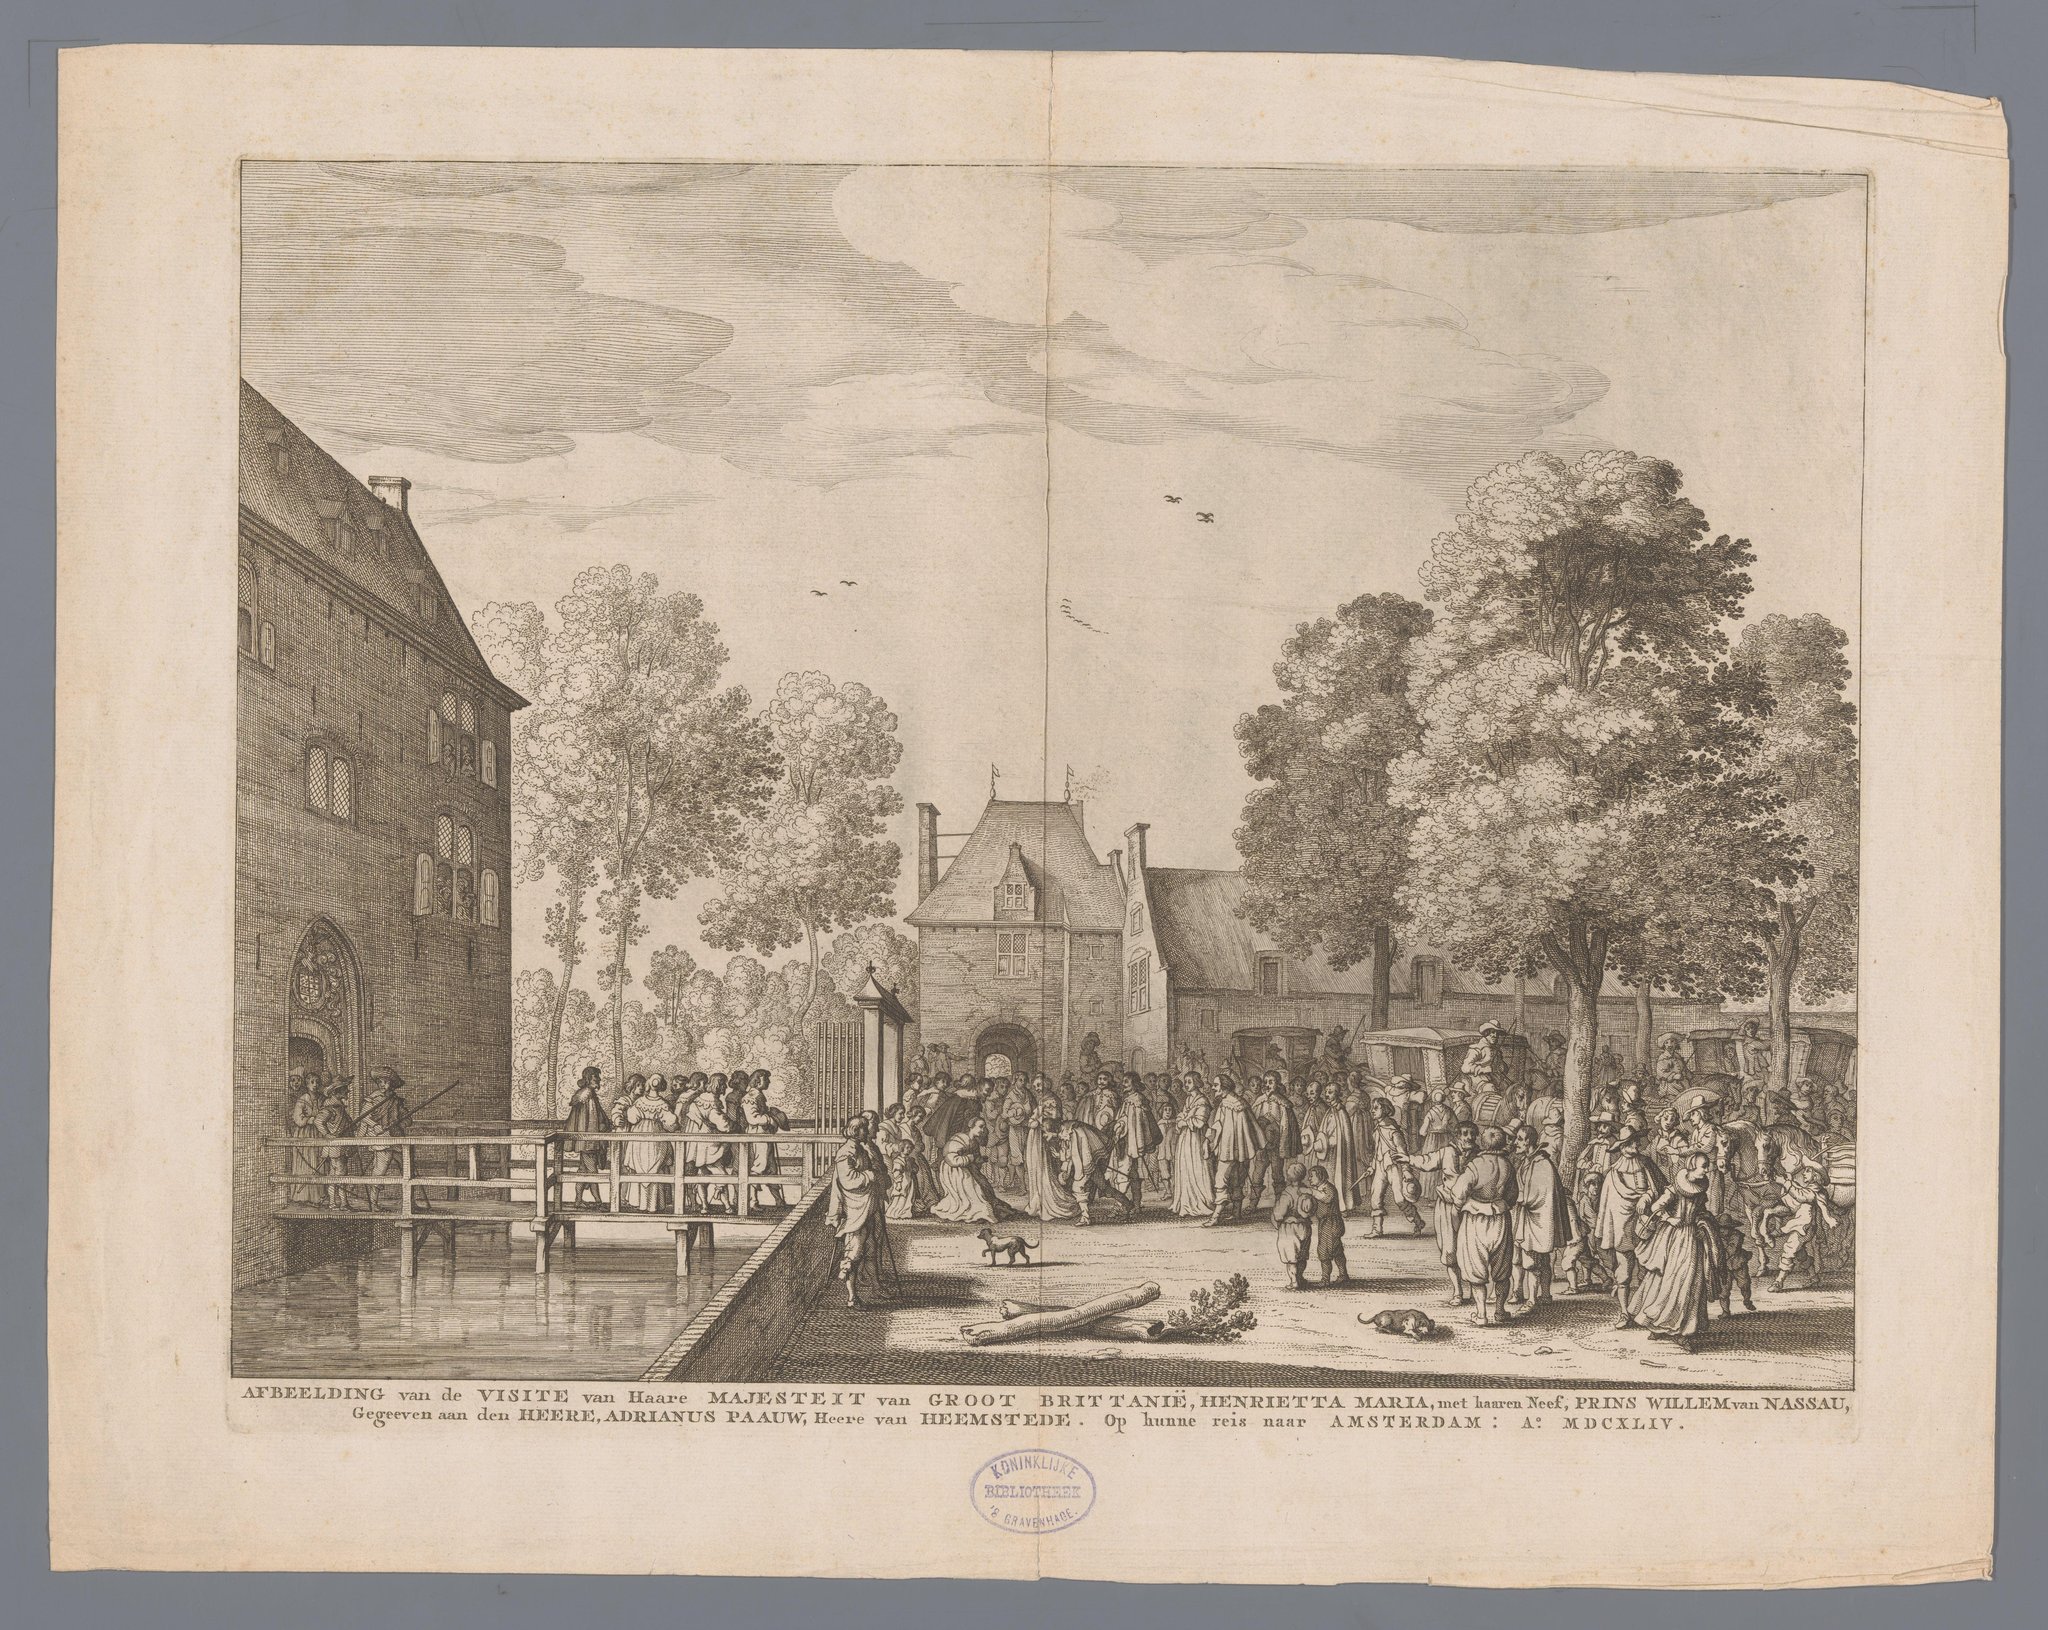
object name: print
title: Bezoek van koningin Henrietta Maria aan Adriaen Pauw op het Slot te Heemstede, 1642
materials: paper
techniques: etching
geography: amsterdam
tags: henriëtta maria van frankrijk (koningin van engeland, schotland en ierland), william ii (prince of orange), politician, adriaen pauw (1585-1653), castle, visiting; receiving guests; elegant company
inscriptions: collector's mark: Lugt 1097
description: Vierde staat met gewijzigd onderschrift met de datum nu in Romeinse cijfers. Een gesigneerde tekening door Jan Martszen de Jonge in spiegelbeeld in particuliere verzameling te Den Haag (in 1977) is mogelijk de ontwerptekening voor deze prent. In de titel op het object staat onterecht het jaartal 1644.